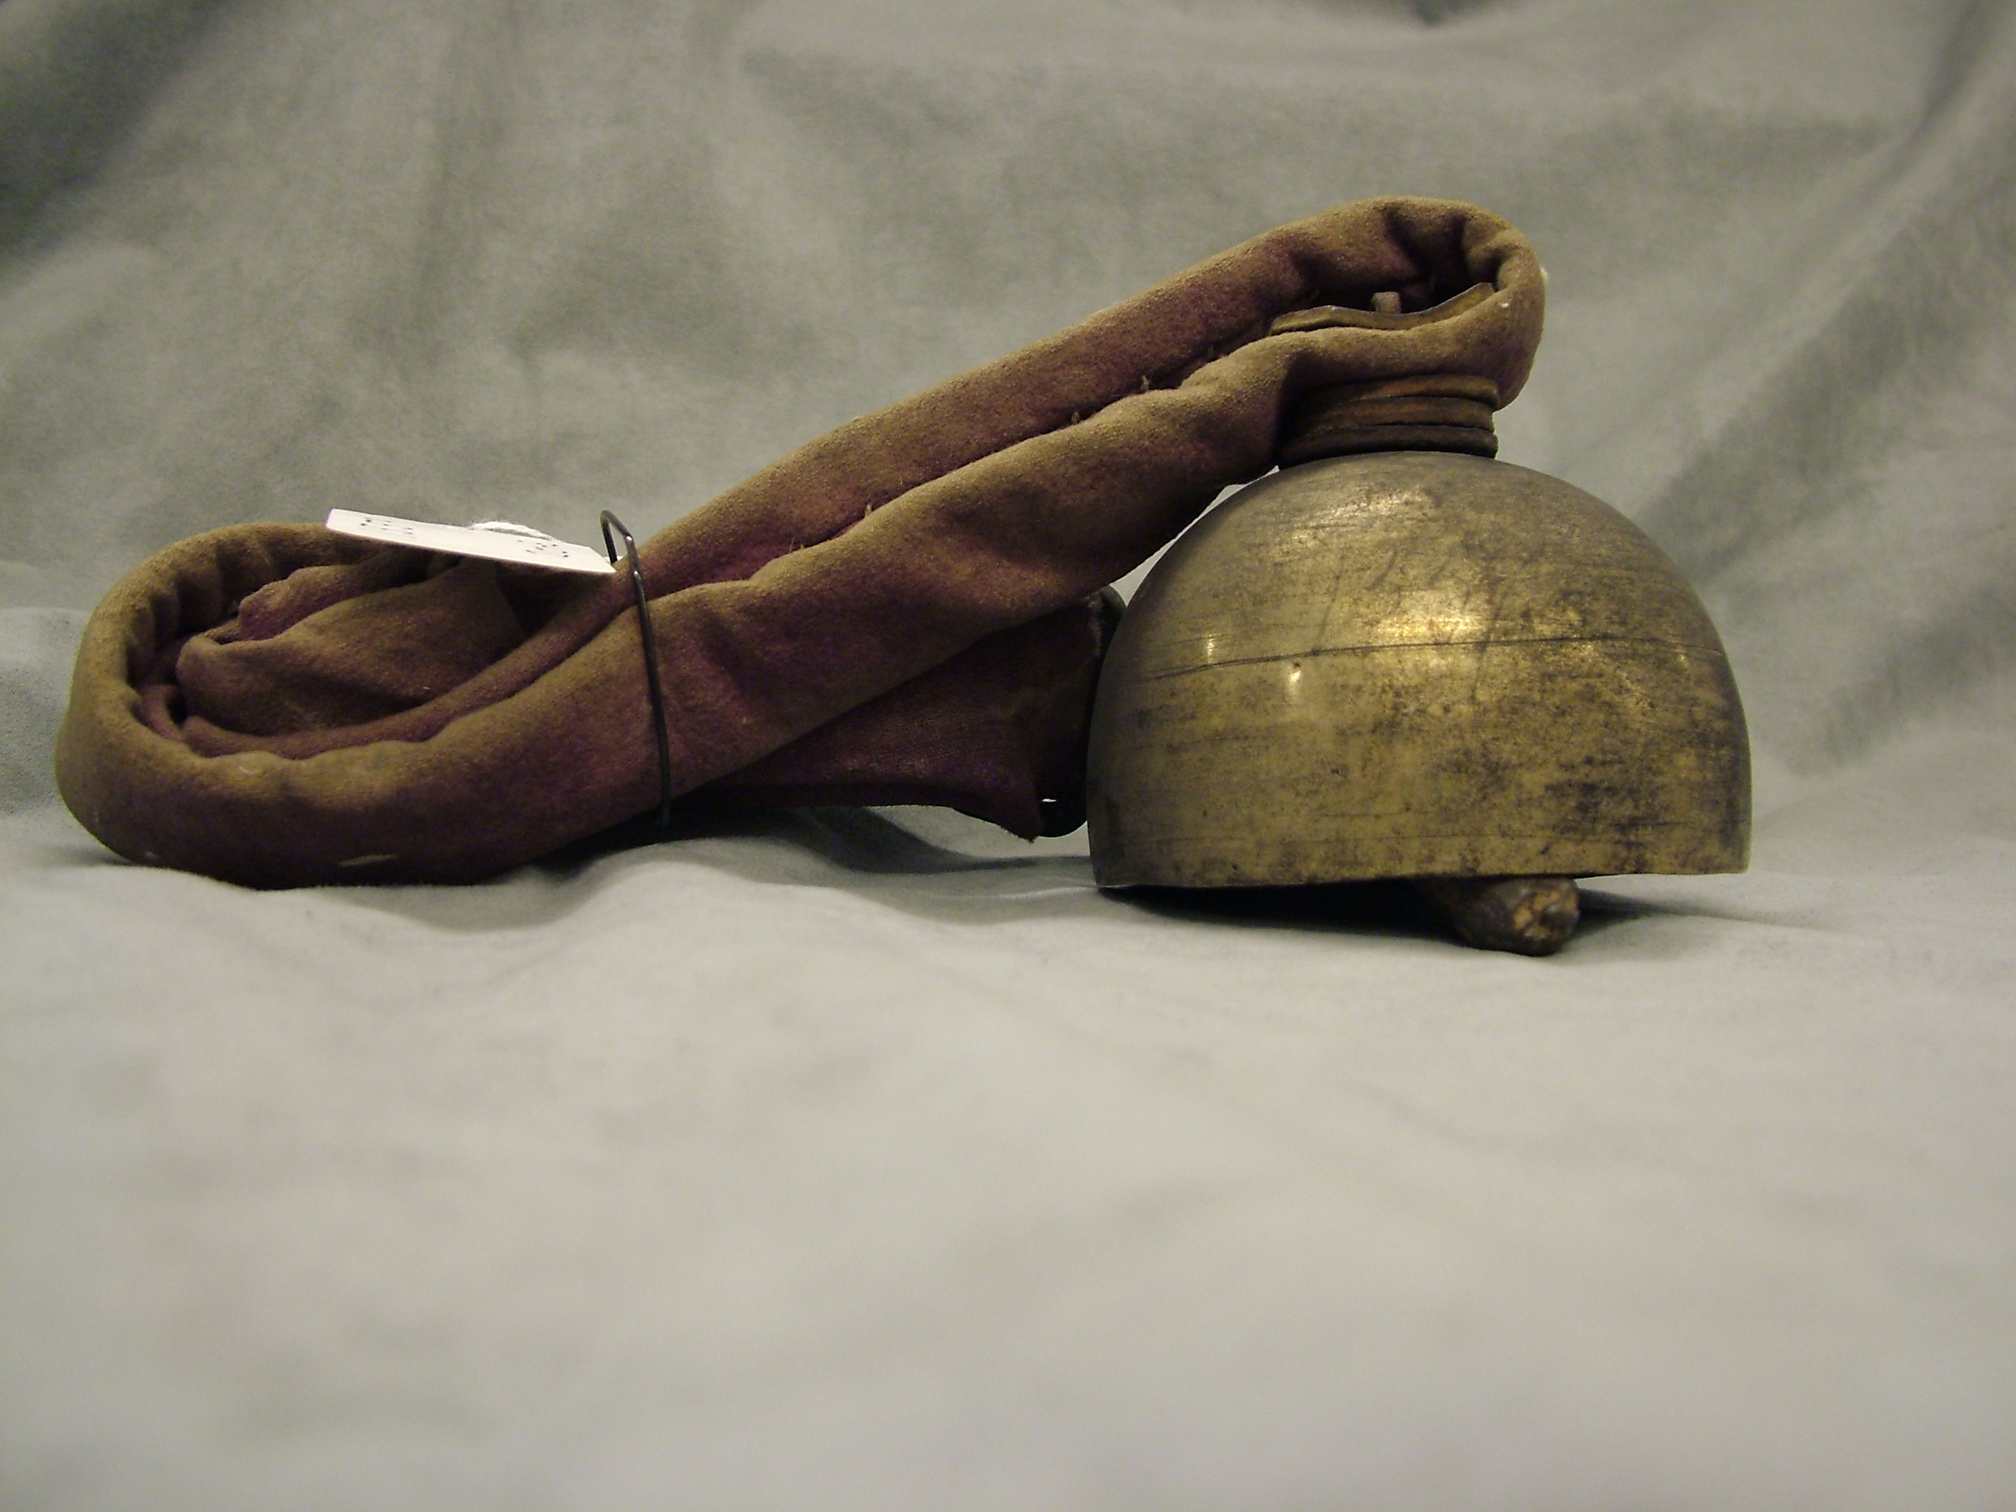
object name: bell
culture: chinese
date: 1801-1900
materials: leather, metal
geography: china